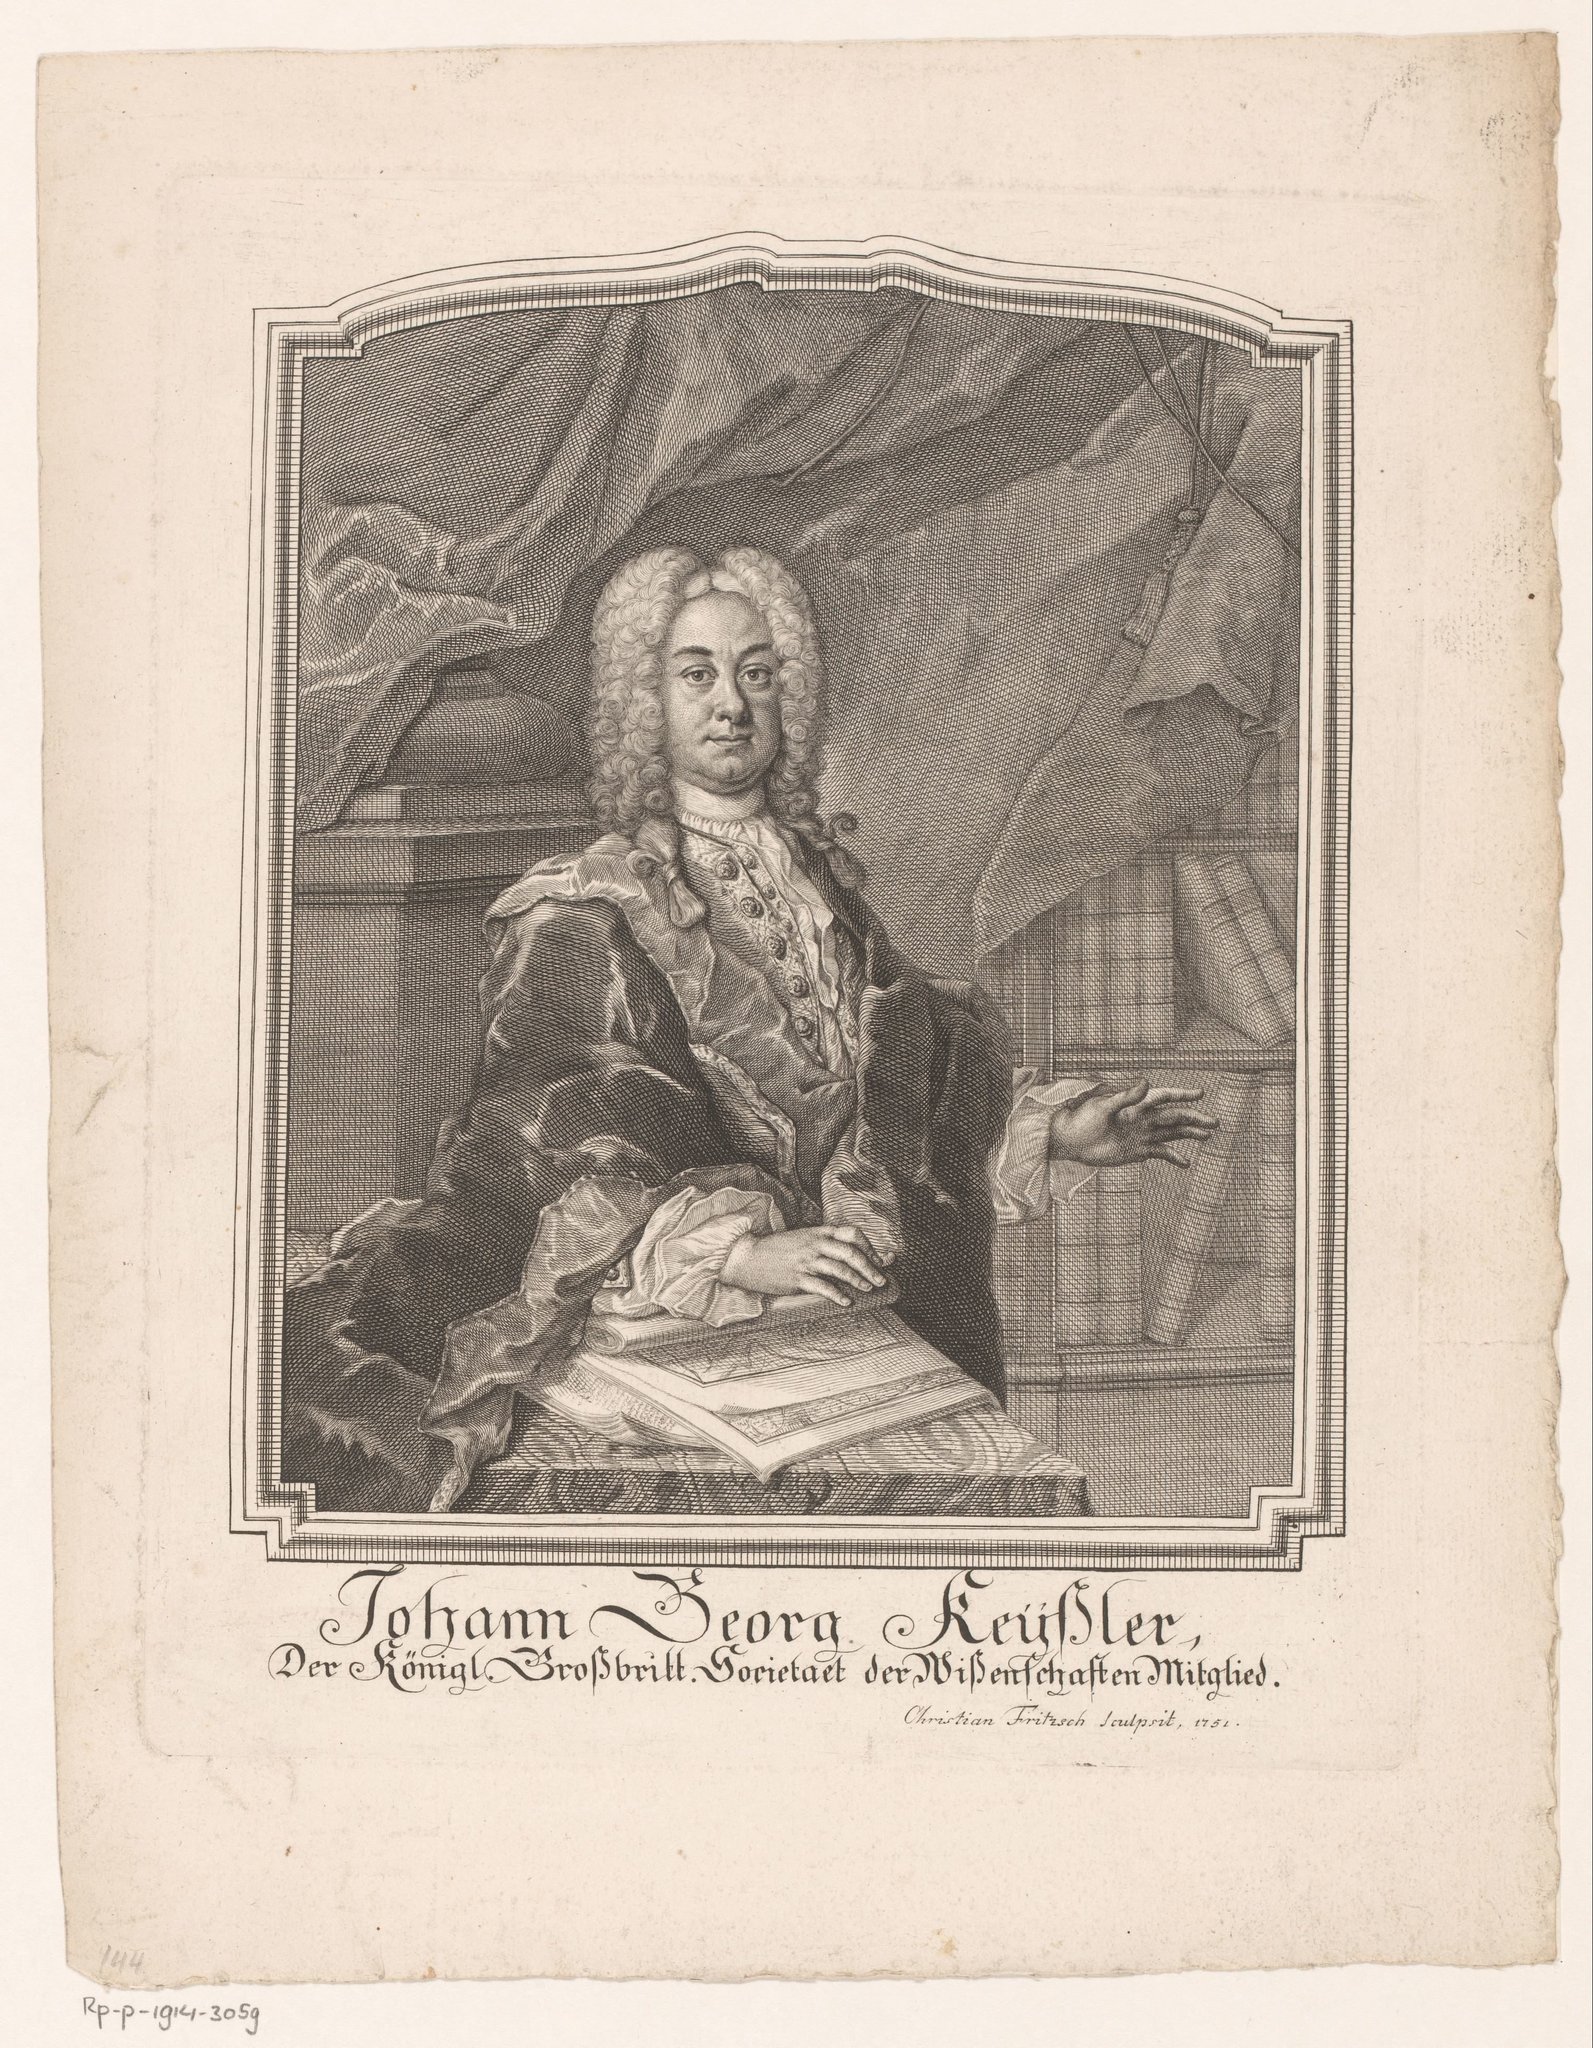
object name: print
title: Portret van Johann Georg Keisler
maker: christian fritzsch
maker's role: print maker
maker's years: 1695-1769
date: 1751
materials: paper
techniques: engraving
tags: bookshelves, maps, atlases, historical persons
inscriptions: collector's mark: Lugt 2228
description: Prent gebruikt voor: Keisler, Johann Georg. Reisen durch Deutschland, Böhmen, Ungarn, die Schweiz, Italien und Lothringen (...). Hannover: Christian Friedrich Helwing, 1776.